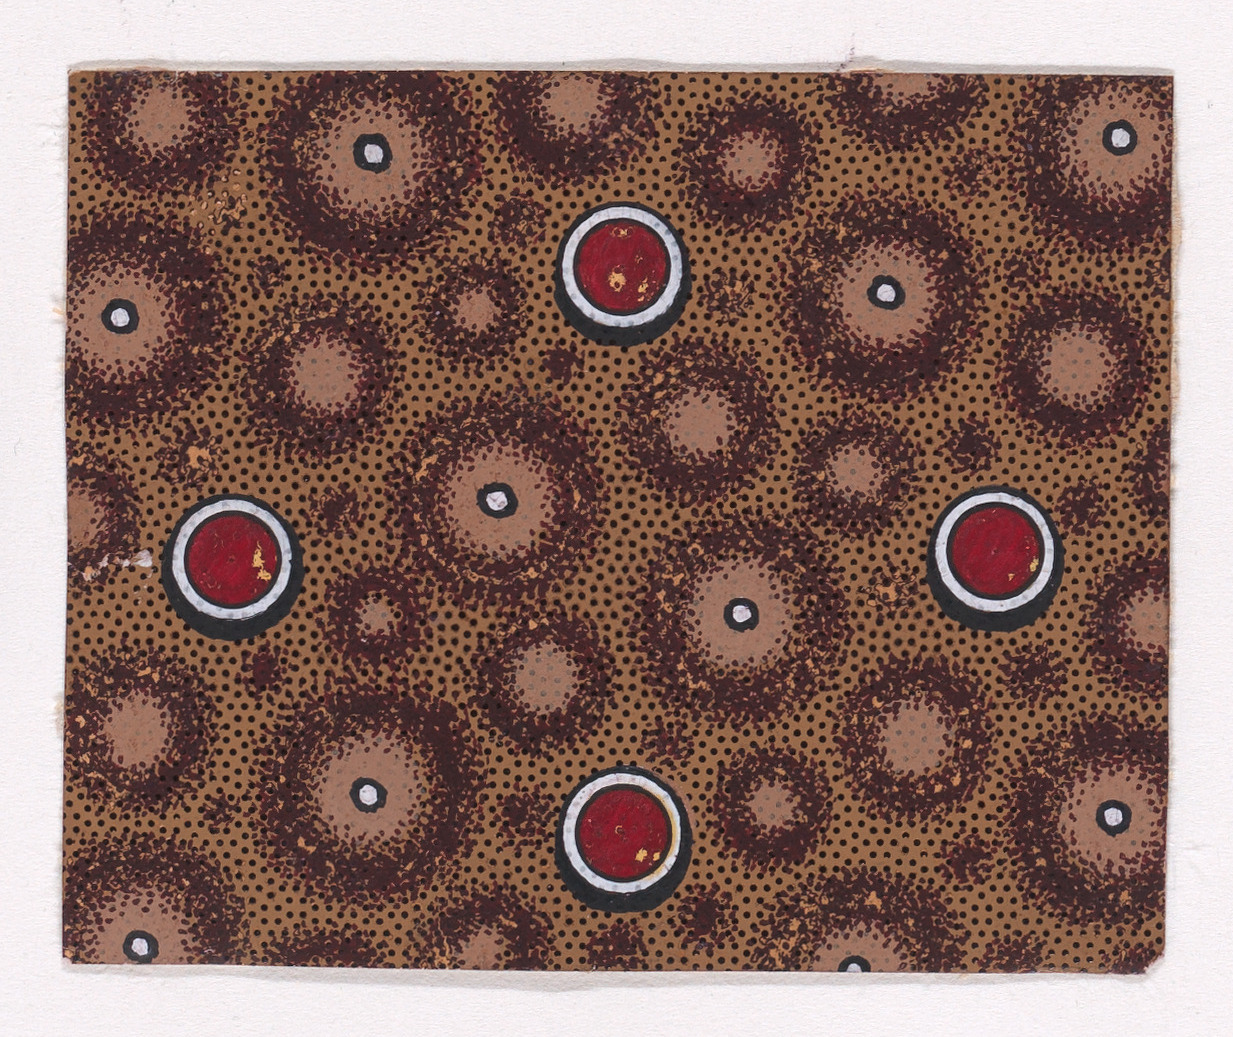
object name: drawing ornament architecture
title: Textile Design with Circles and Pearls over a Stippled Background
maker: anonymous, alsatian, 19th century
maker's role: artist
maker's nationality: alsatian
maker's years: 1800-1900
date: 1840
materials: gouache